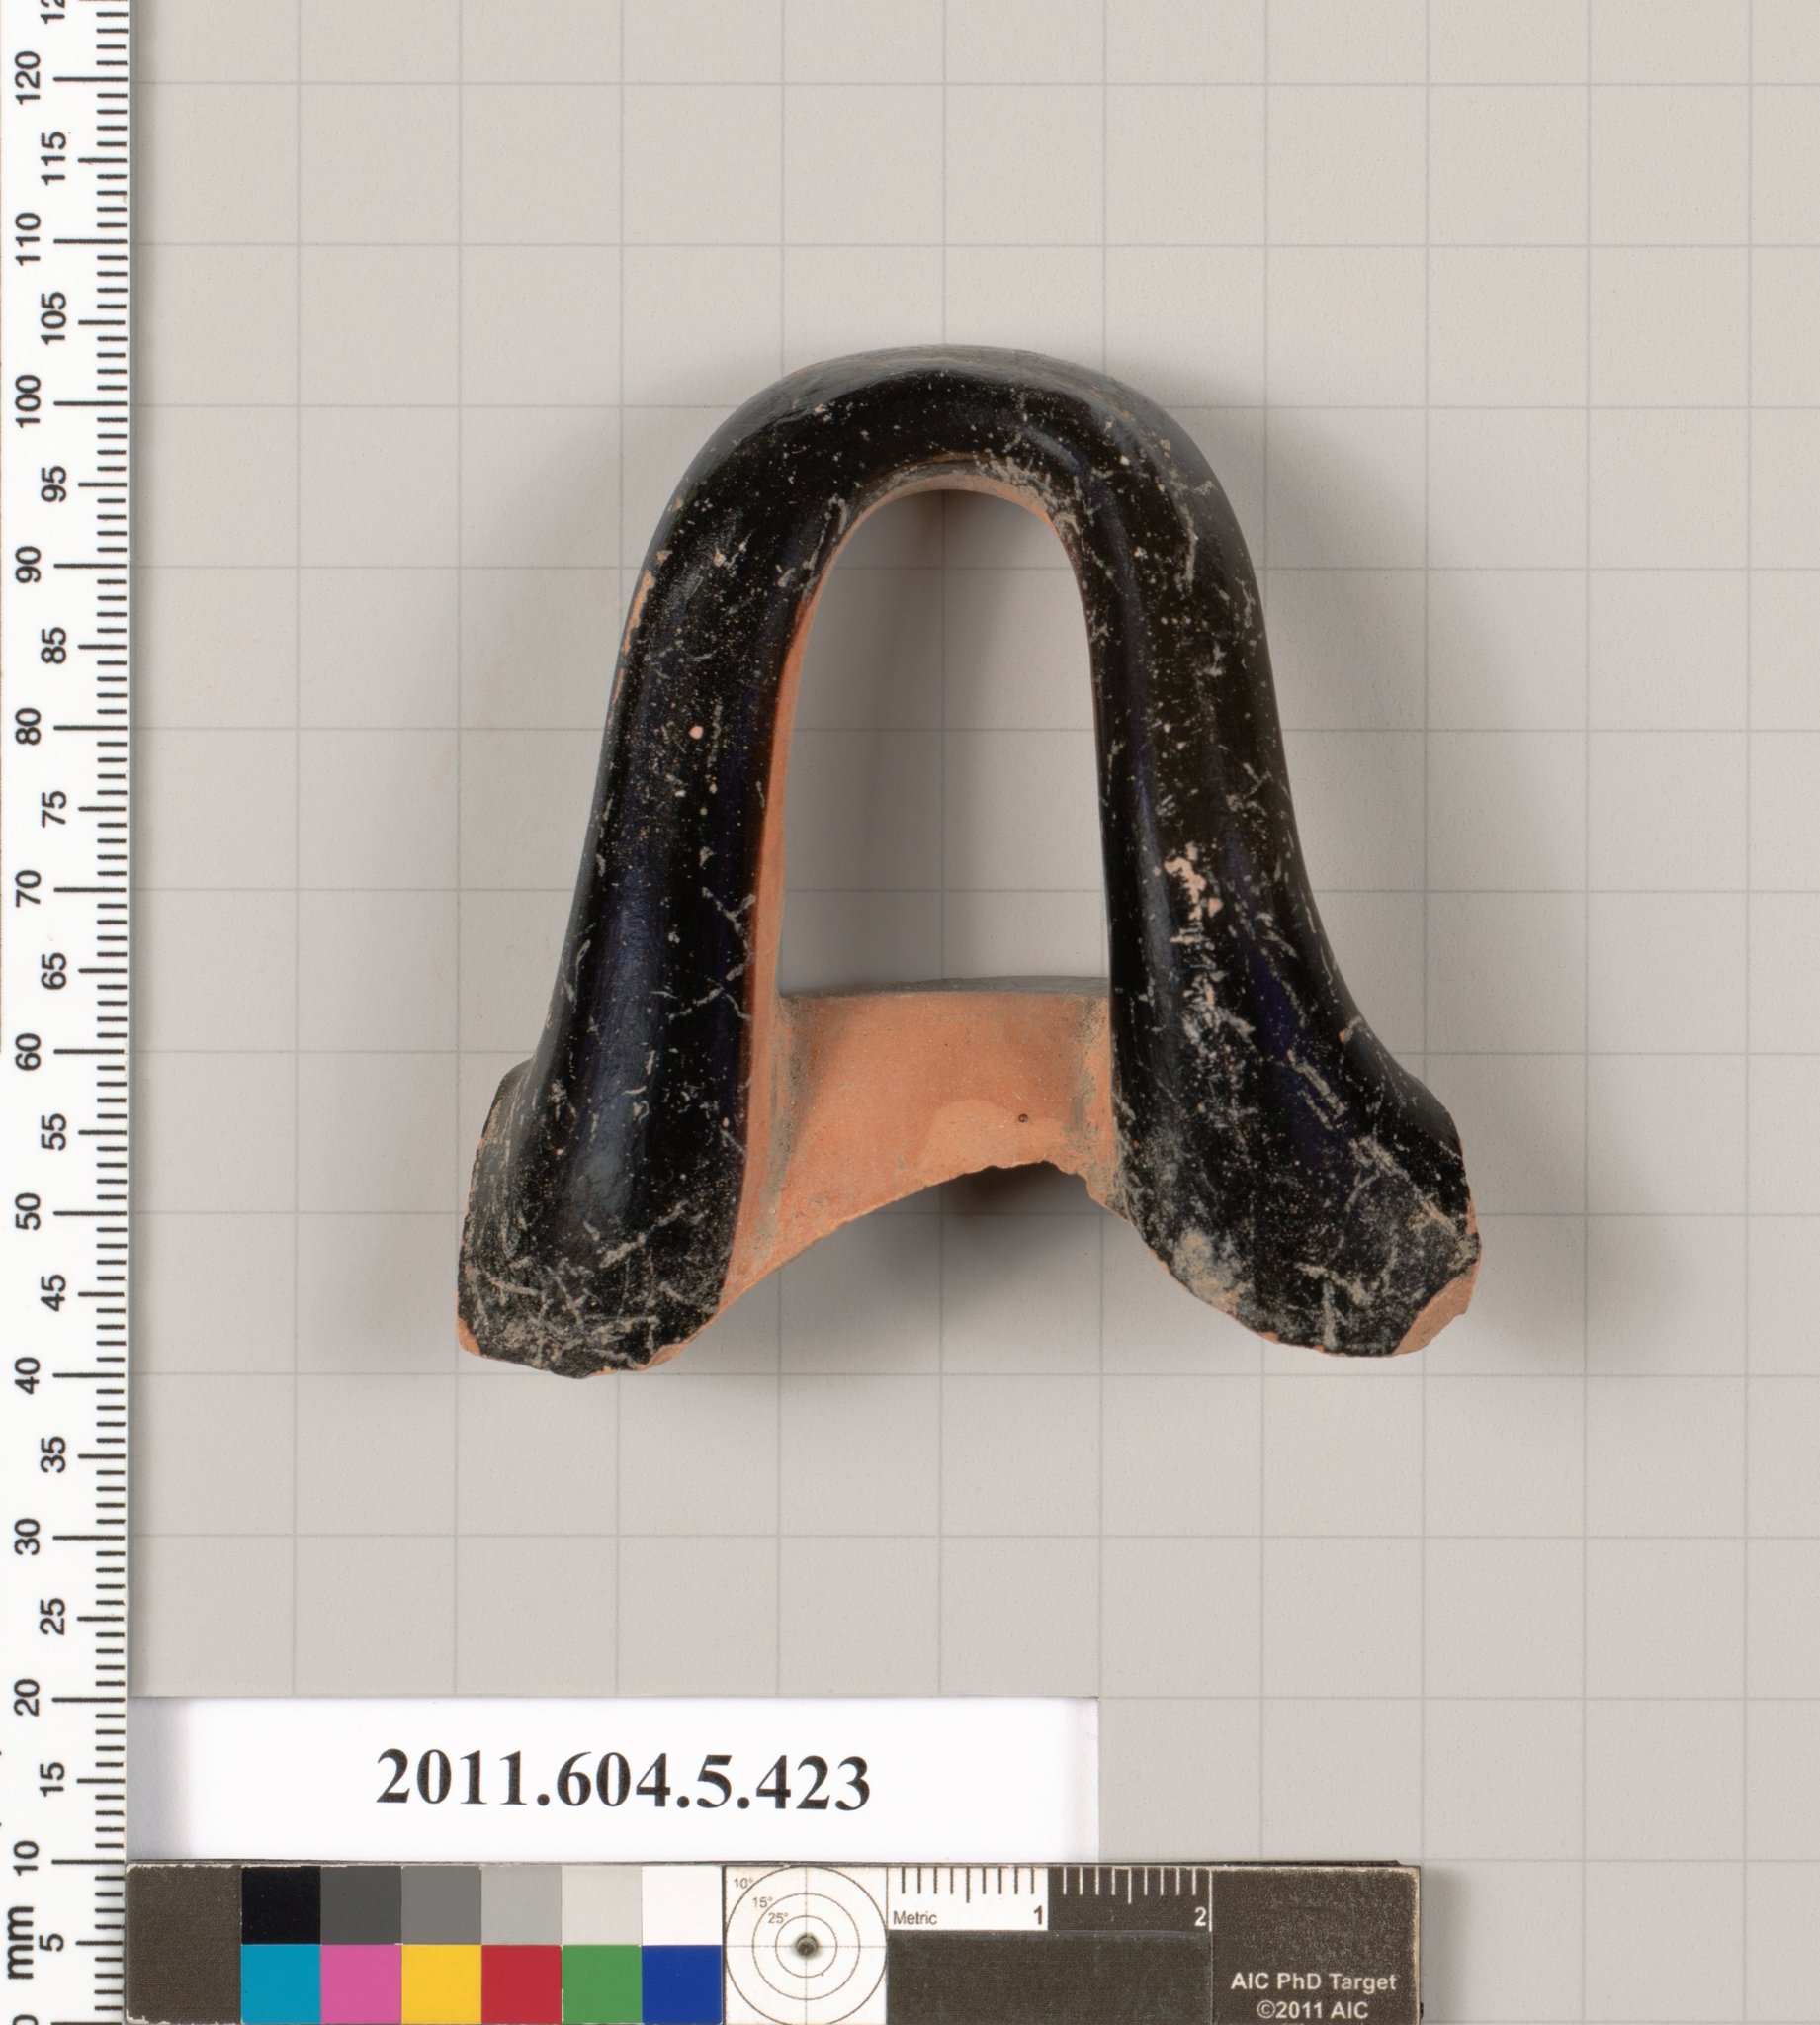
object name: kylix fragment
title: Terracotta rim fragment of a kylix (drinking cup)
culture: greek, attic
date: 600-401 BCE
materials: terracotta